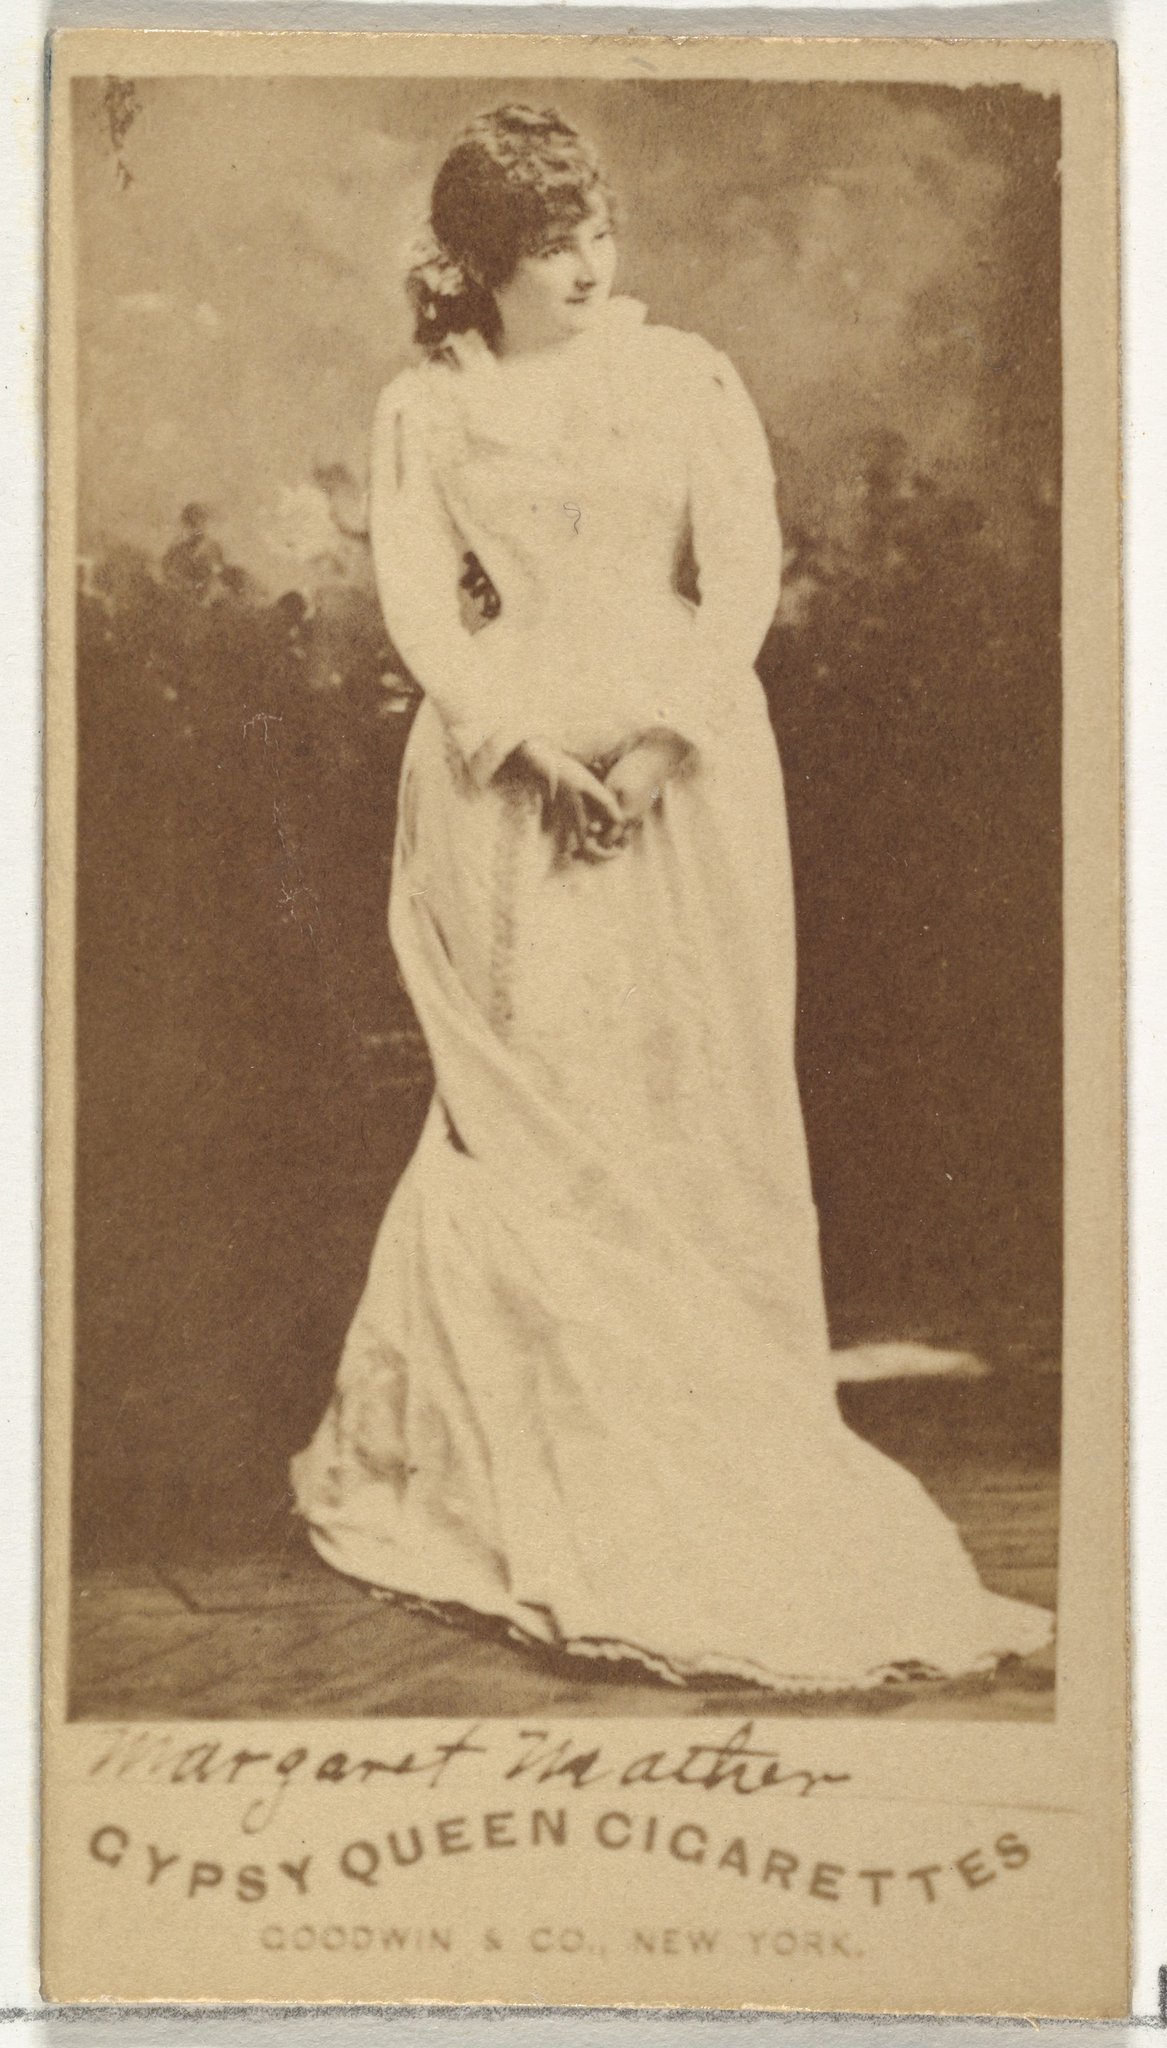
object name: photograph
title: Margaret Mather, from the Actors and Actresses series (N171) for Gypsy Queen Cigarettes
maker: goodwin & company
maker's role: publisher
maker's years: 1850-1950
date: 1886-1890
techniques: albumen silver print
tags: portraits,women,actresses